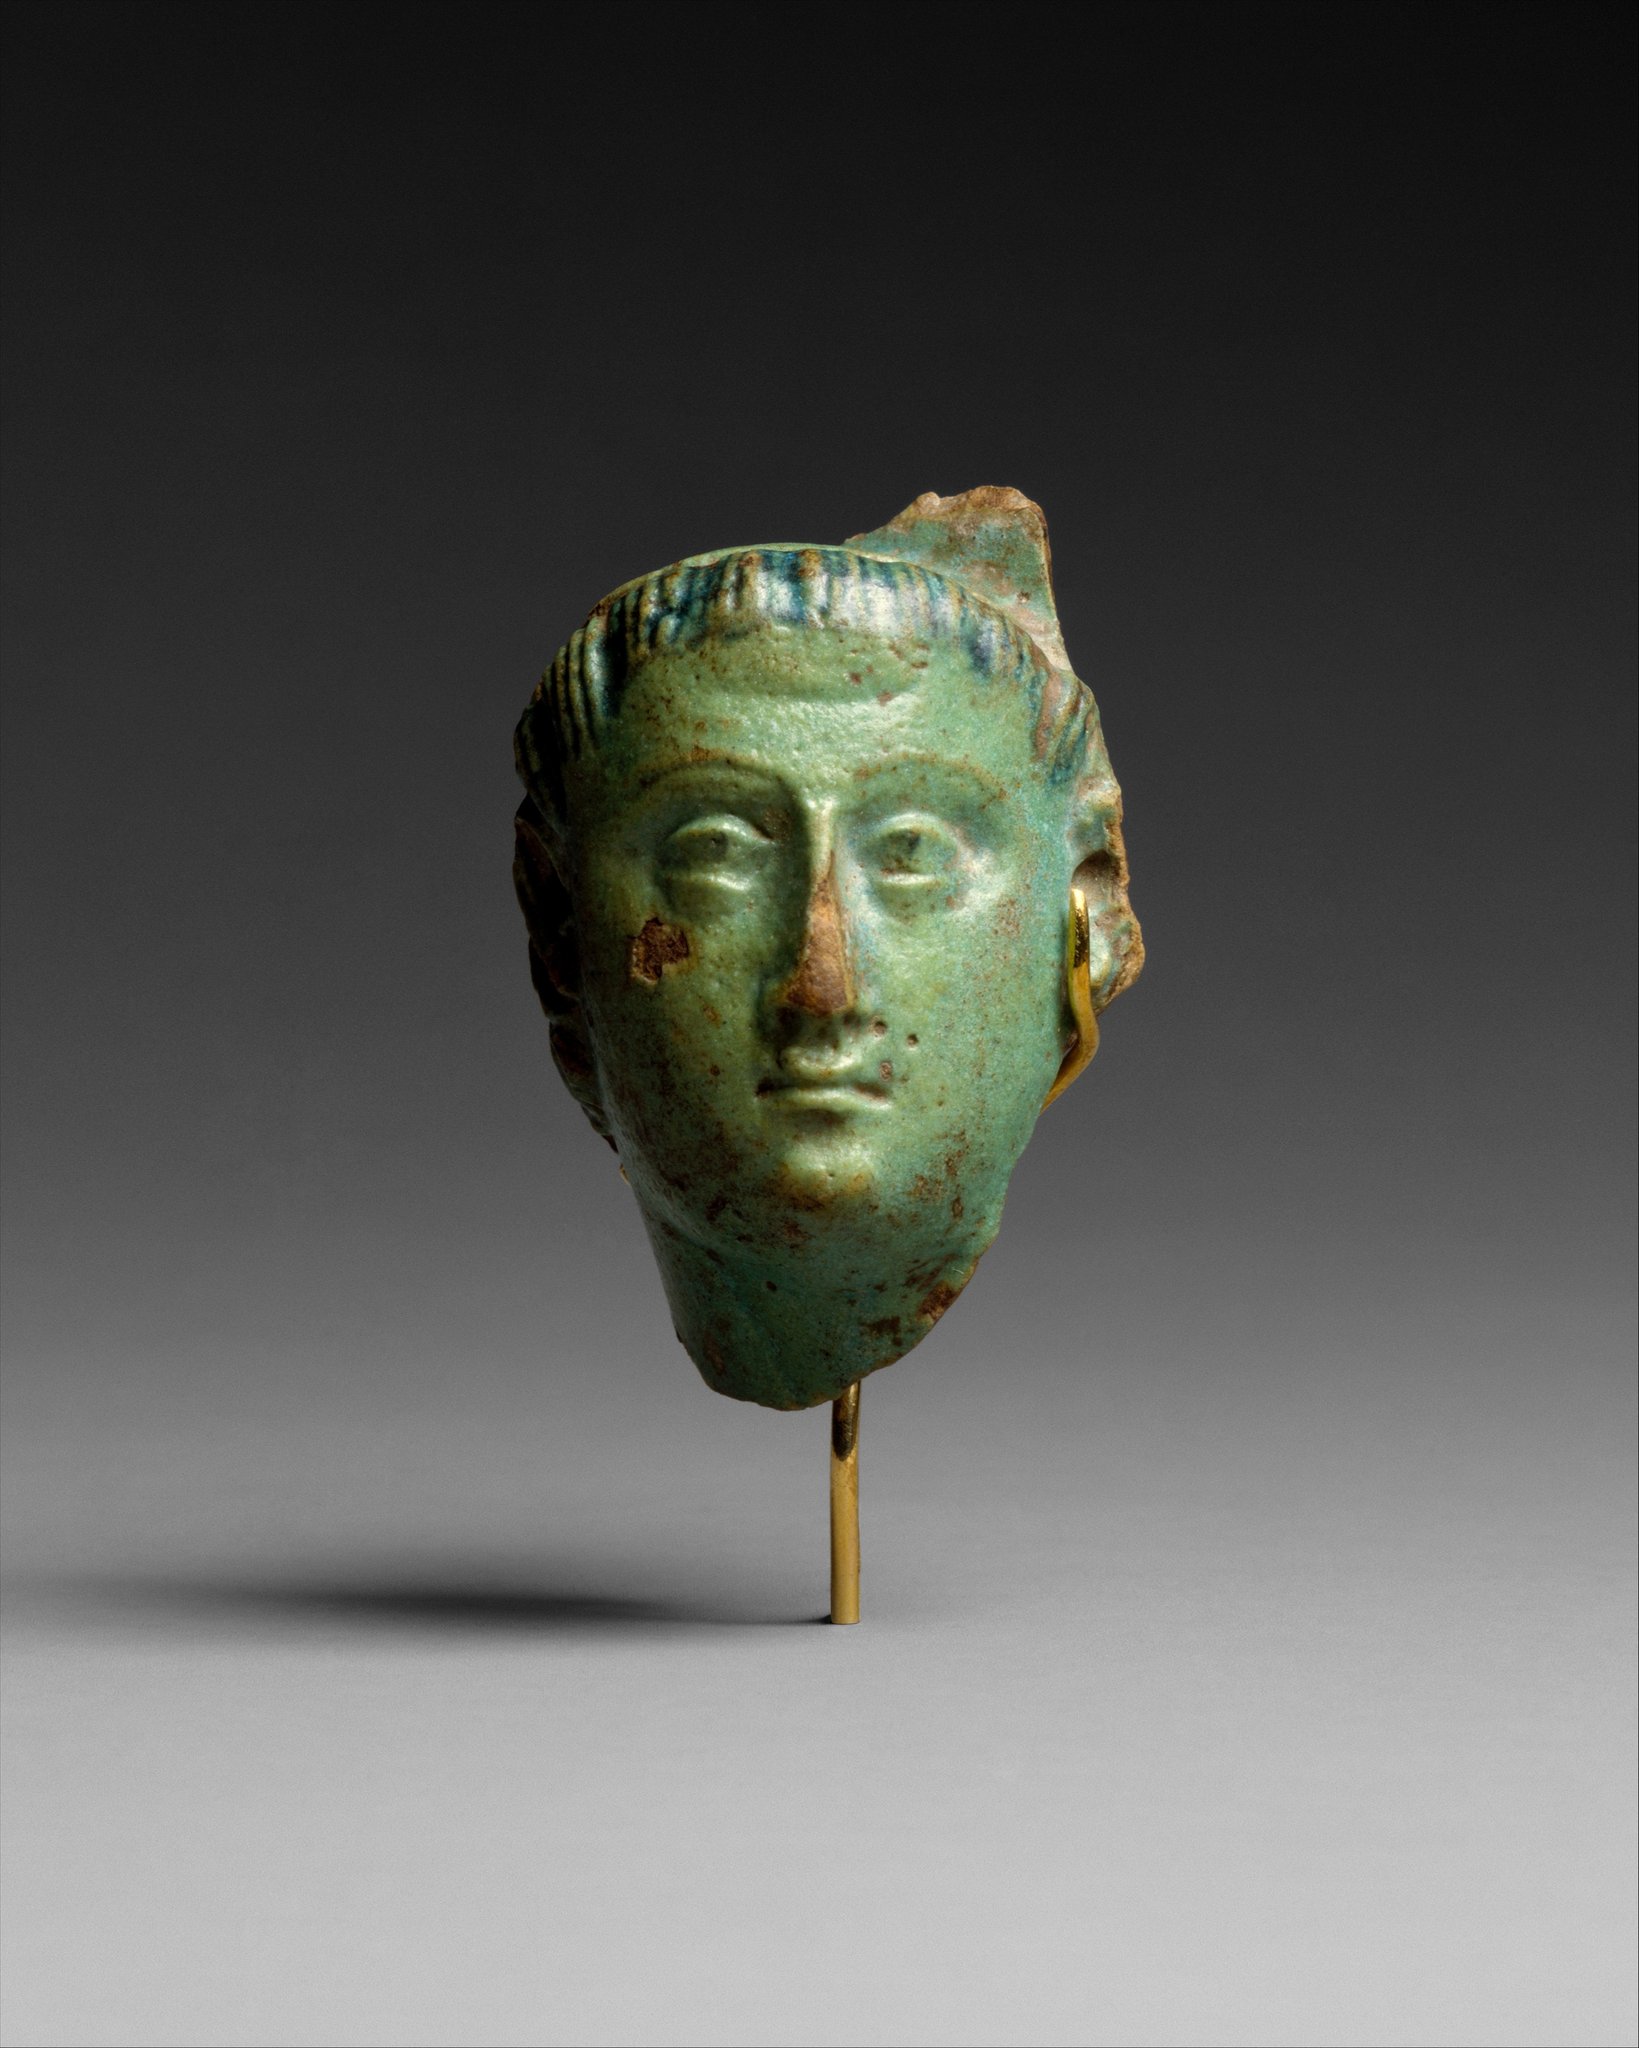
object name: head, ptolemy iii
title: Head, Ptolemy III (?)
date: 246-222 BCE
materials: faience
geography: egypt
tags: kings,heads